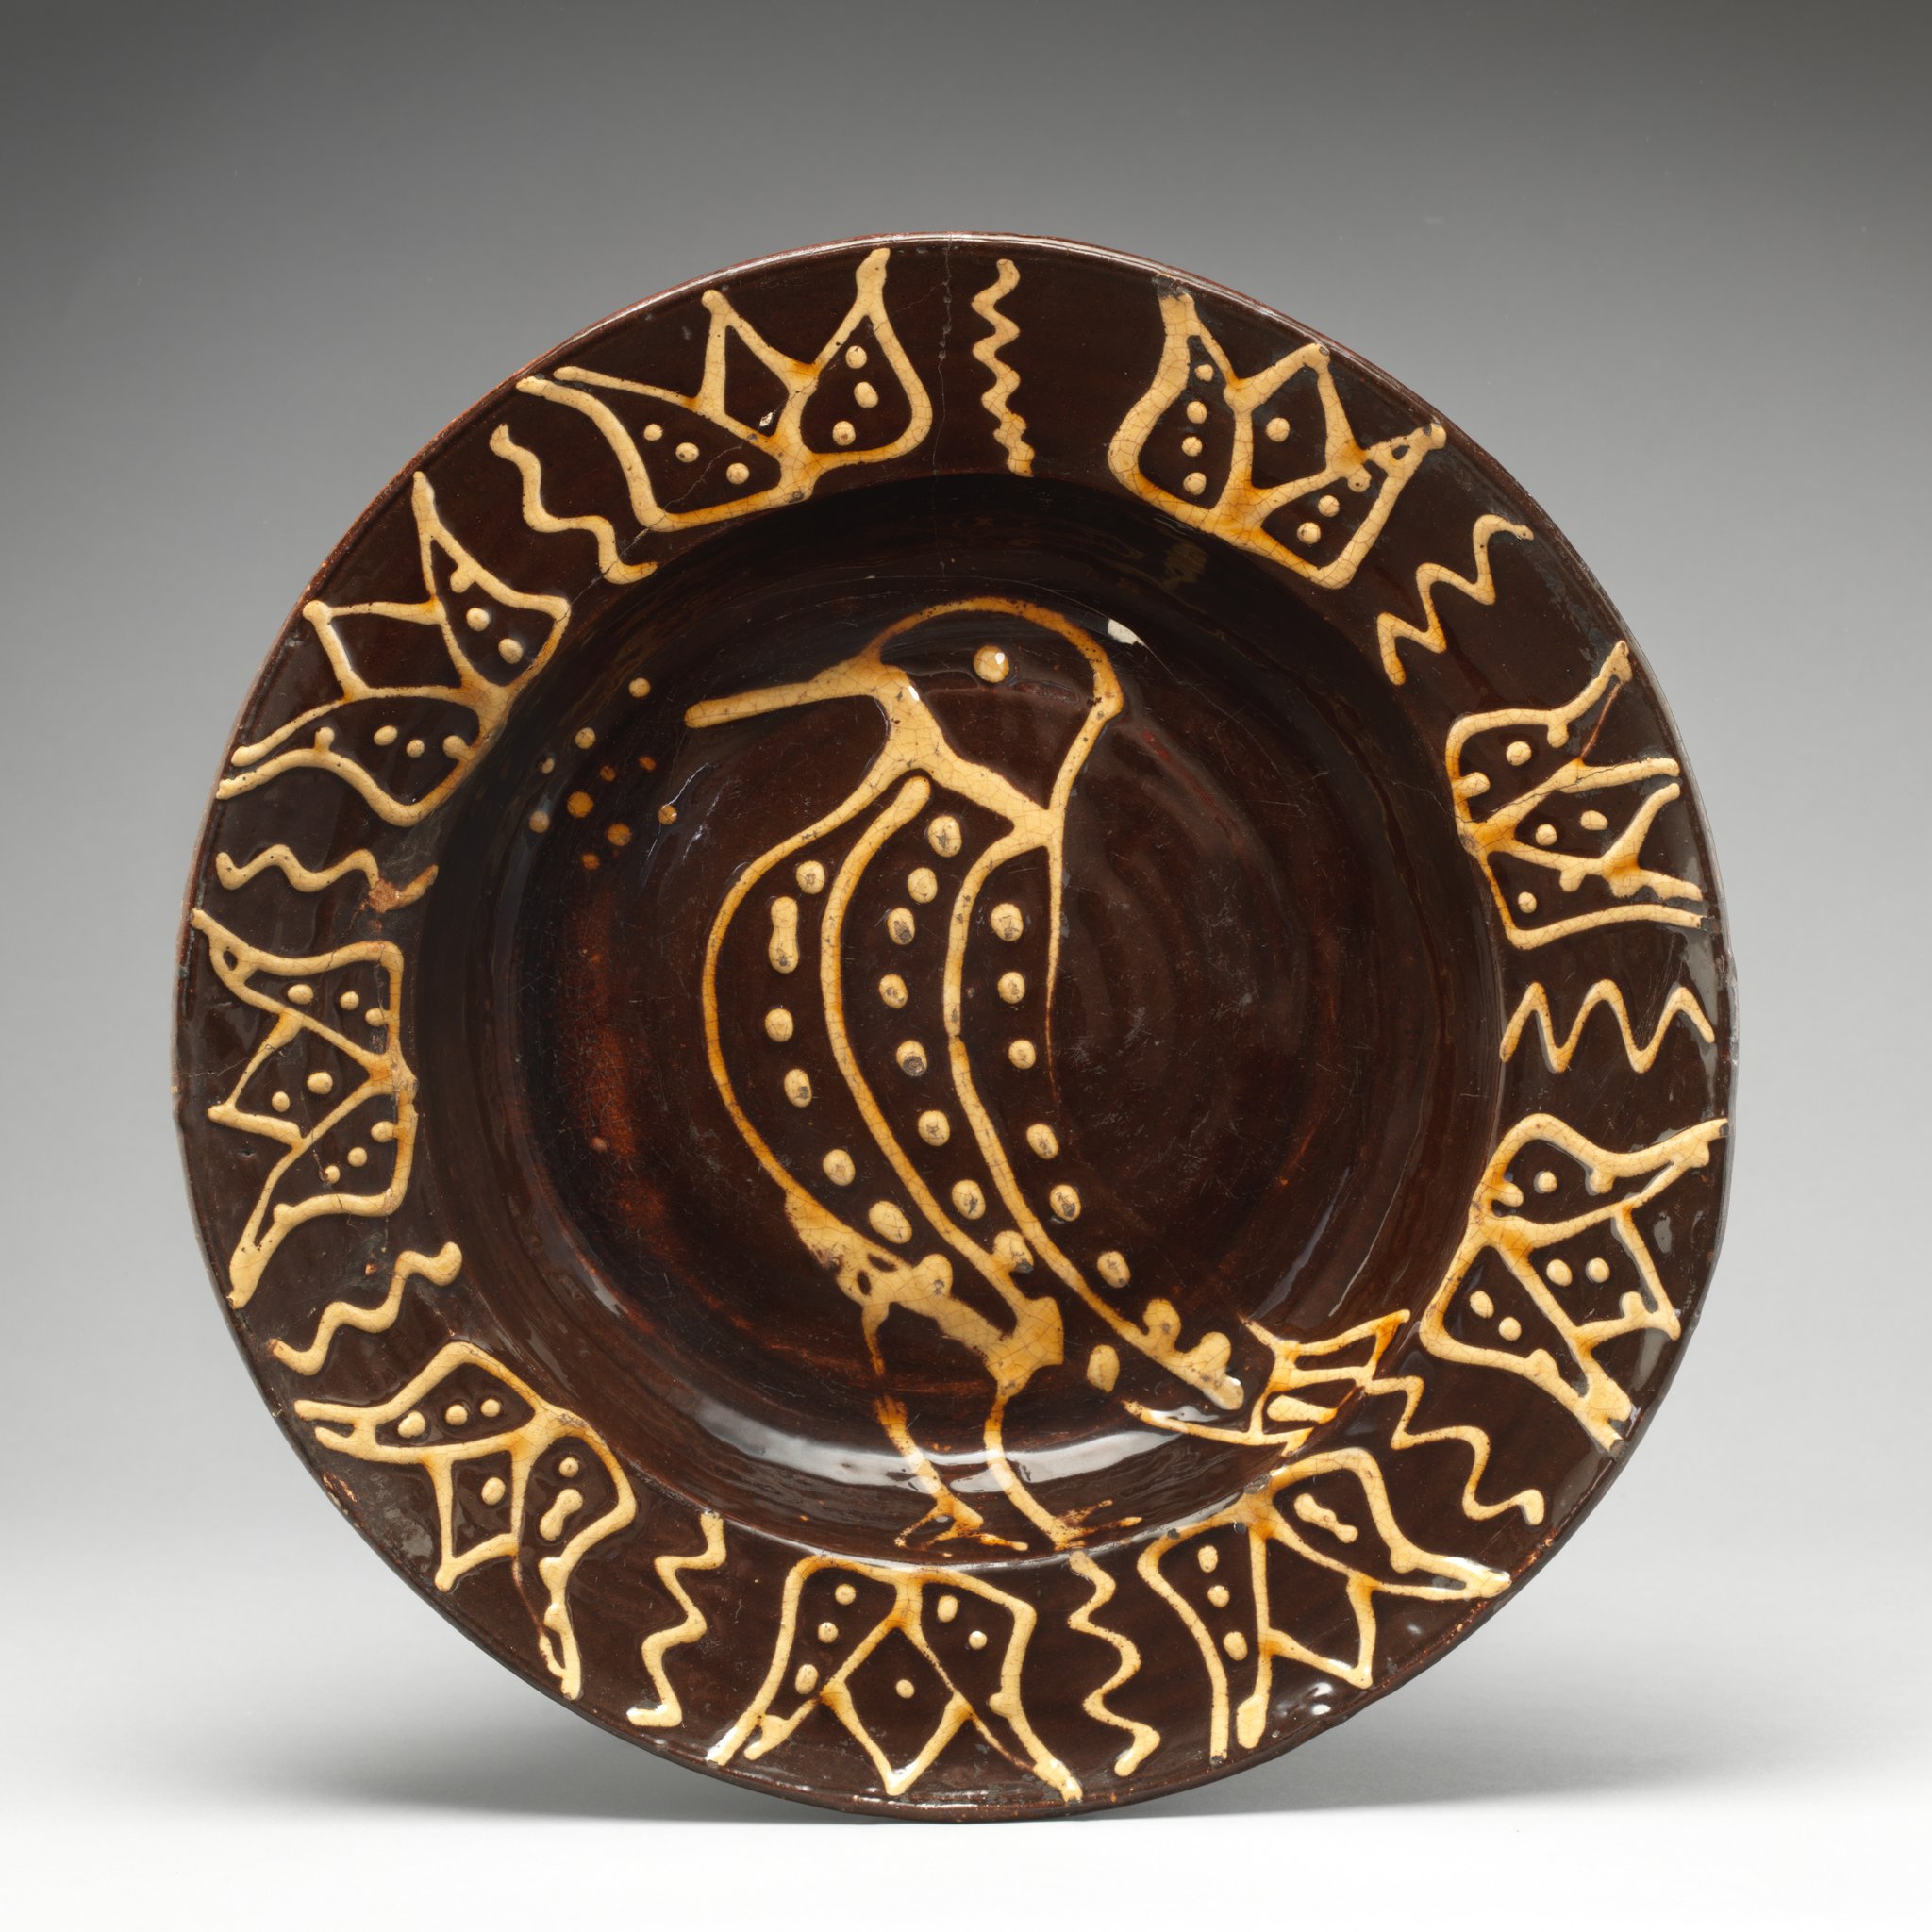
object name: dish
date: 1700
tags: birds